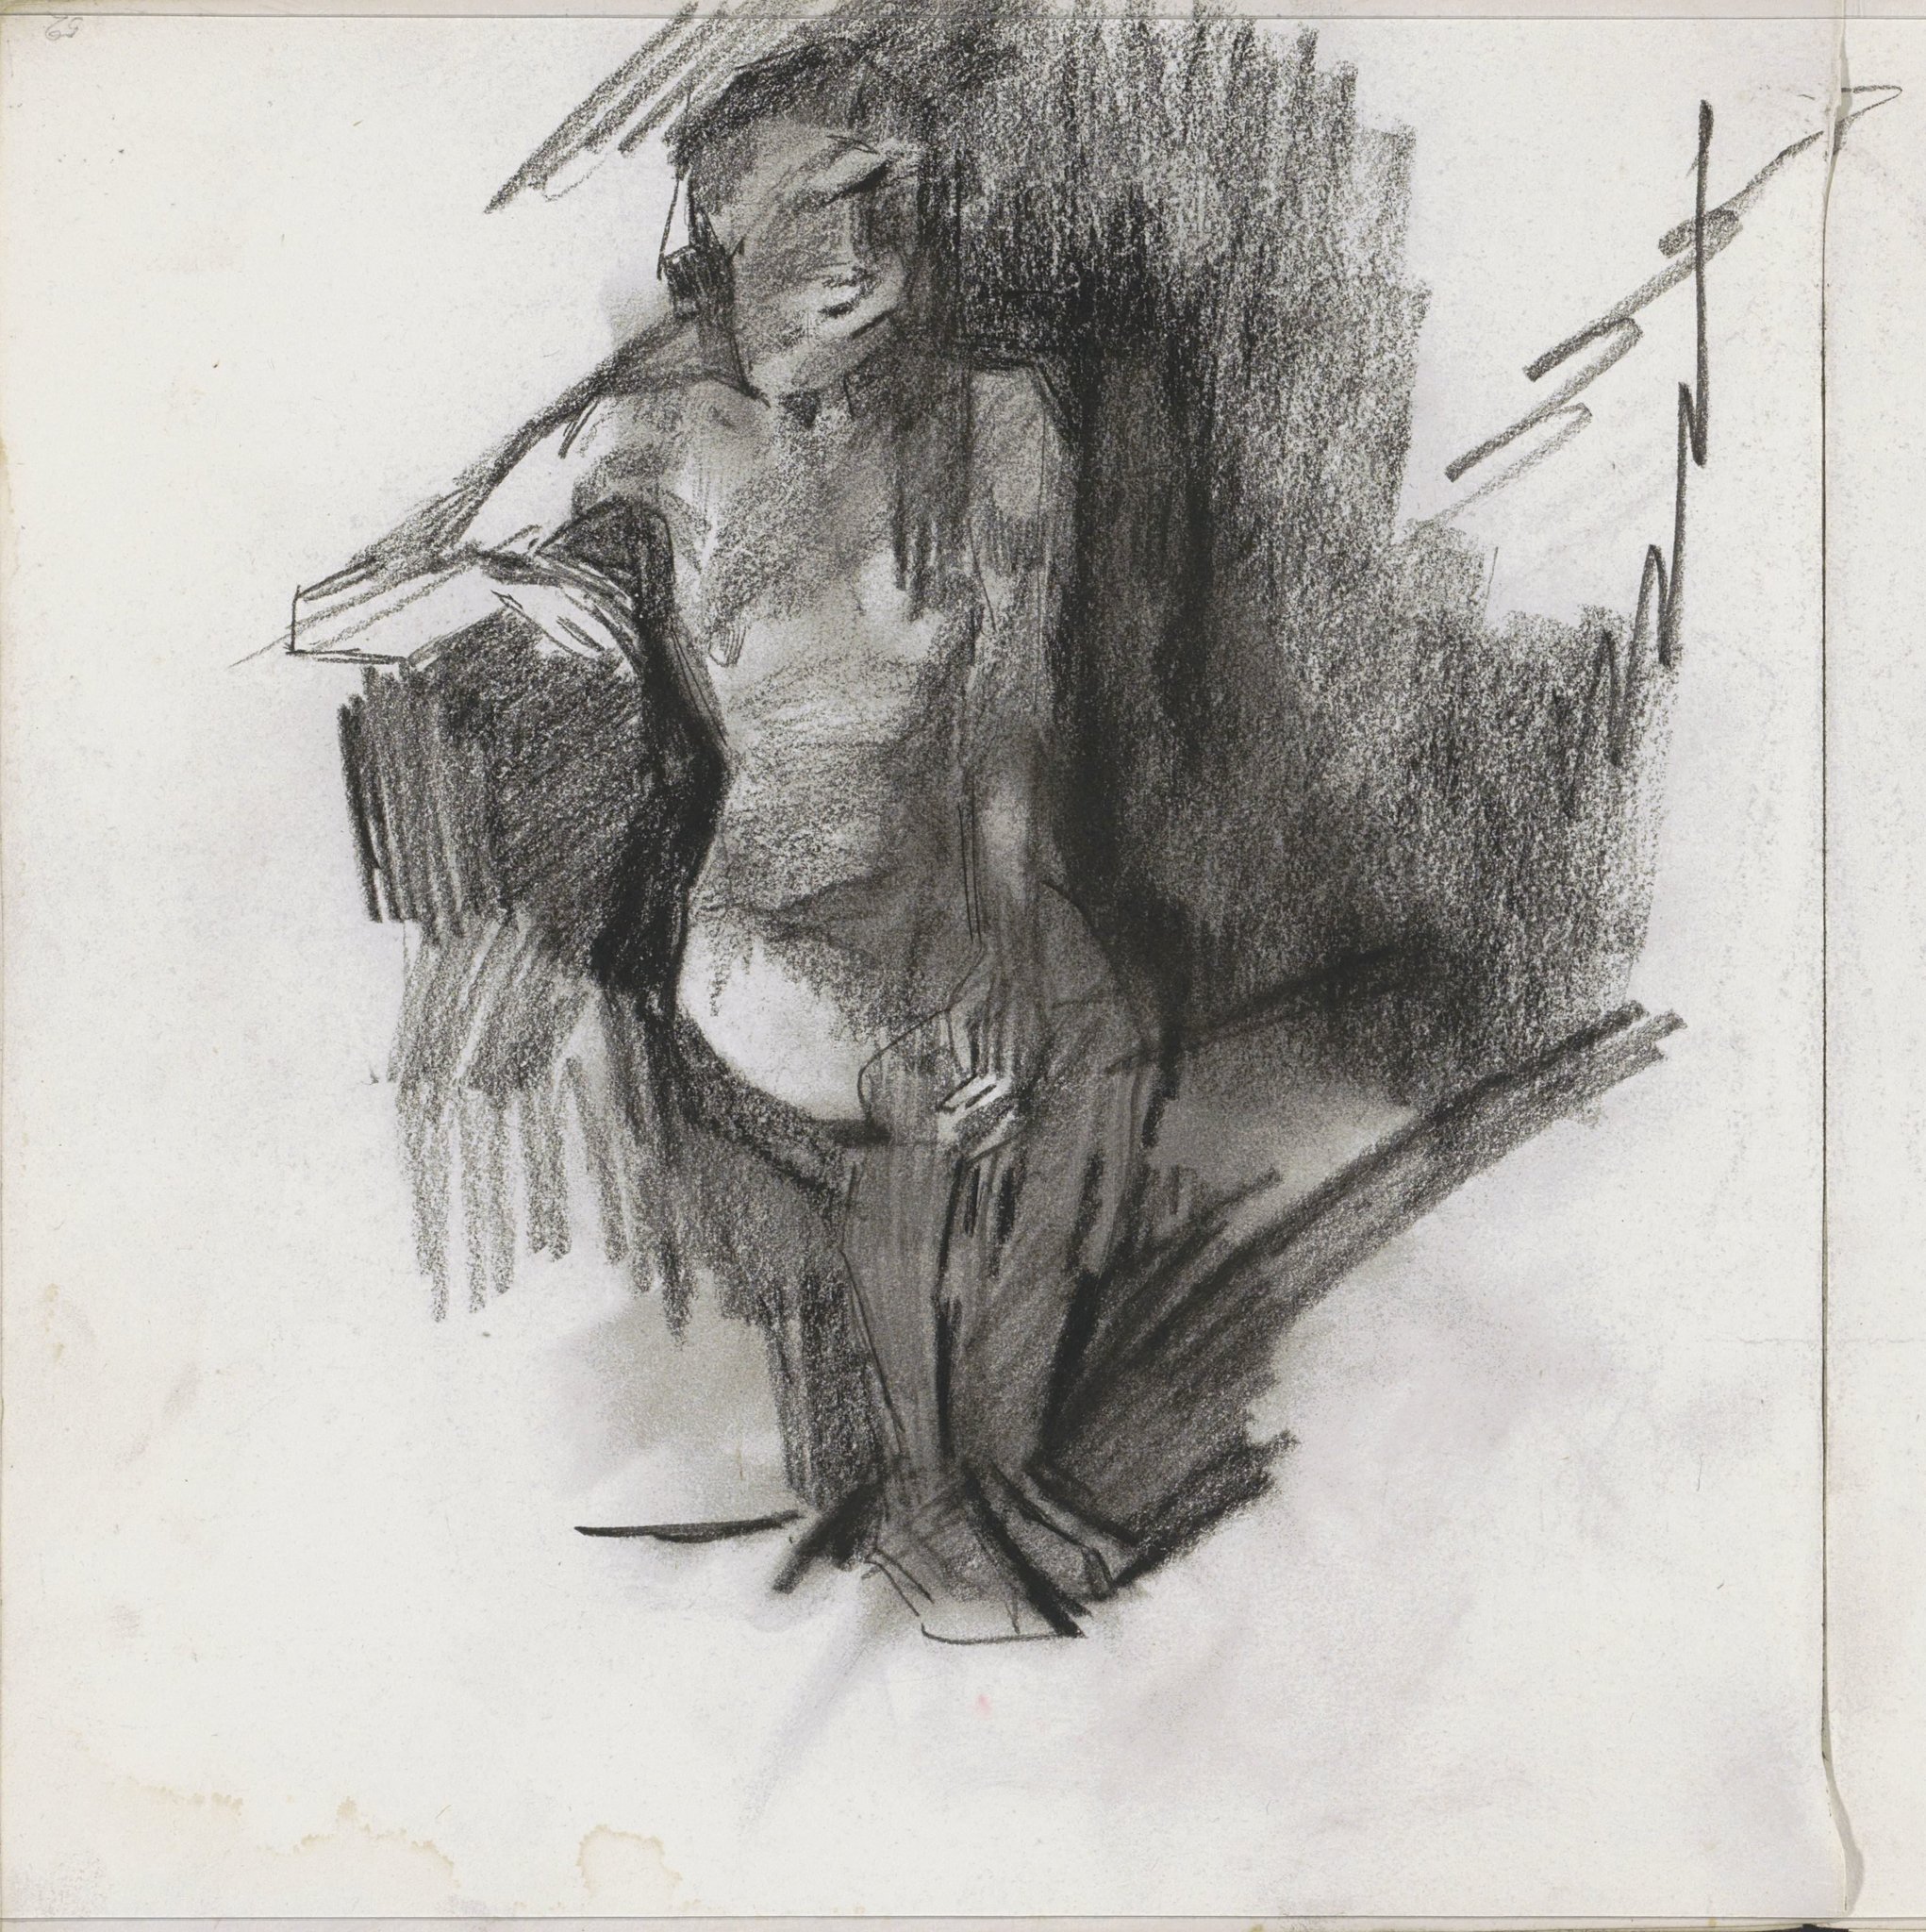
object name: sketchbook leaf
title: Seated Female Nude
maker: isaac israels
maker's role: draughtsman, painter, print maker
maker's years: 1865-1934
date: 1875-1934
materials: chalk, paper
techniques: stumping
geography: the hague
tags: the (nude) human figure; 'corpo humano' (ripa) - aa - female human figure (+ sitting)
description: Met opgeheven rechterarm. Blad 5 verso uit schetsboek IX met 28 bladen.